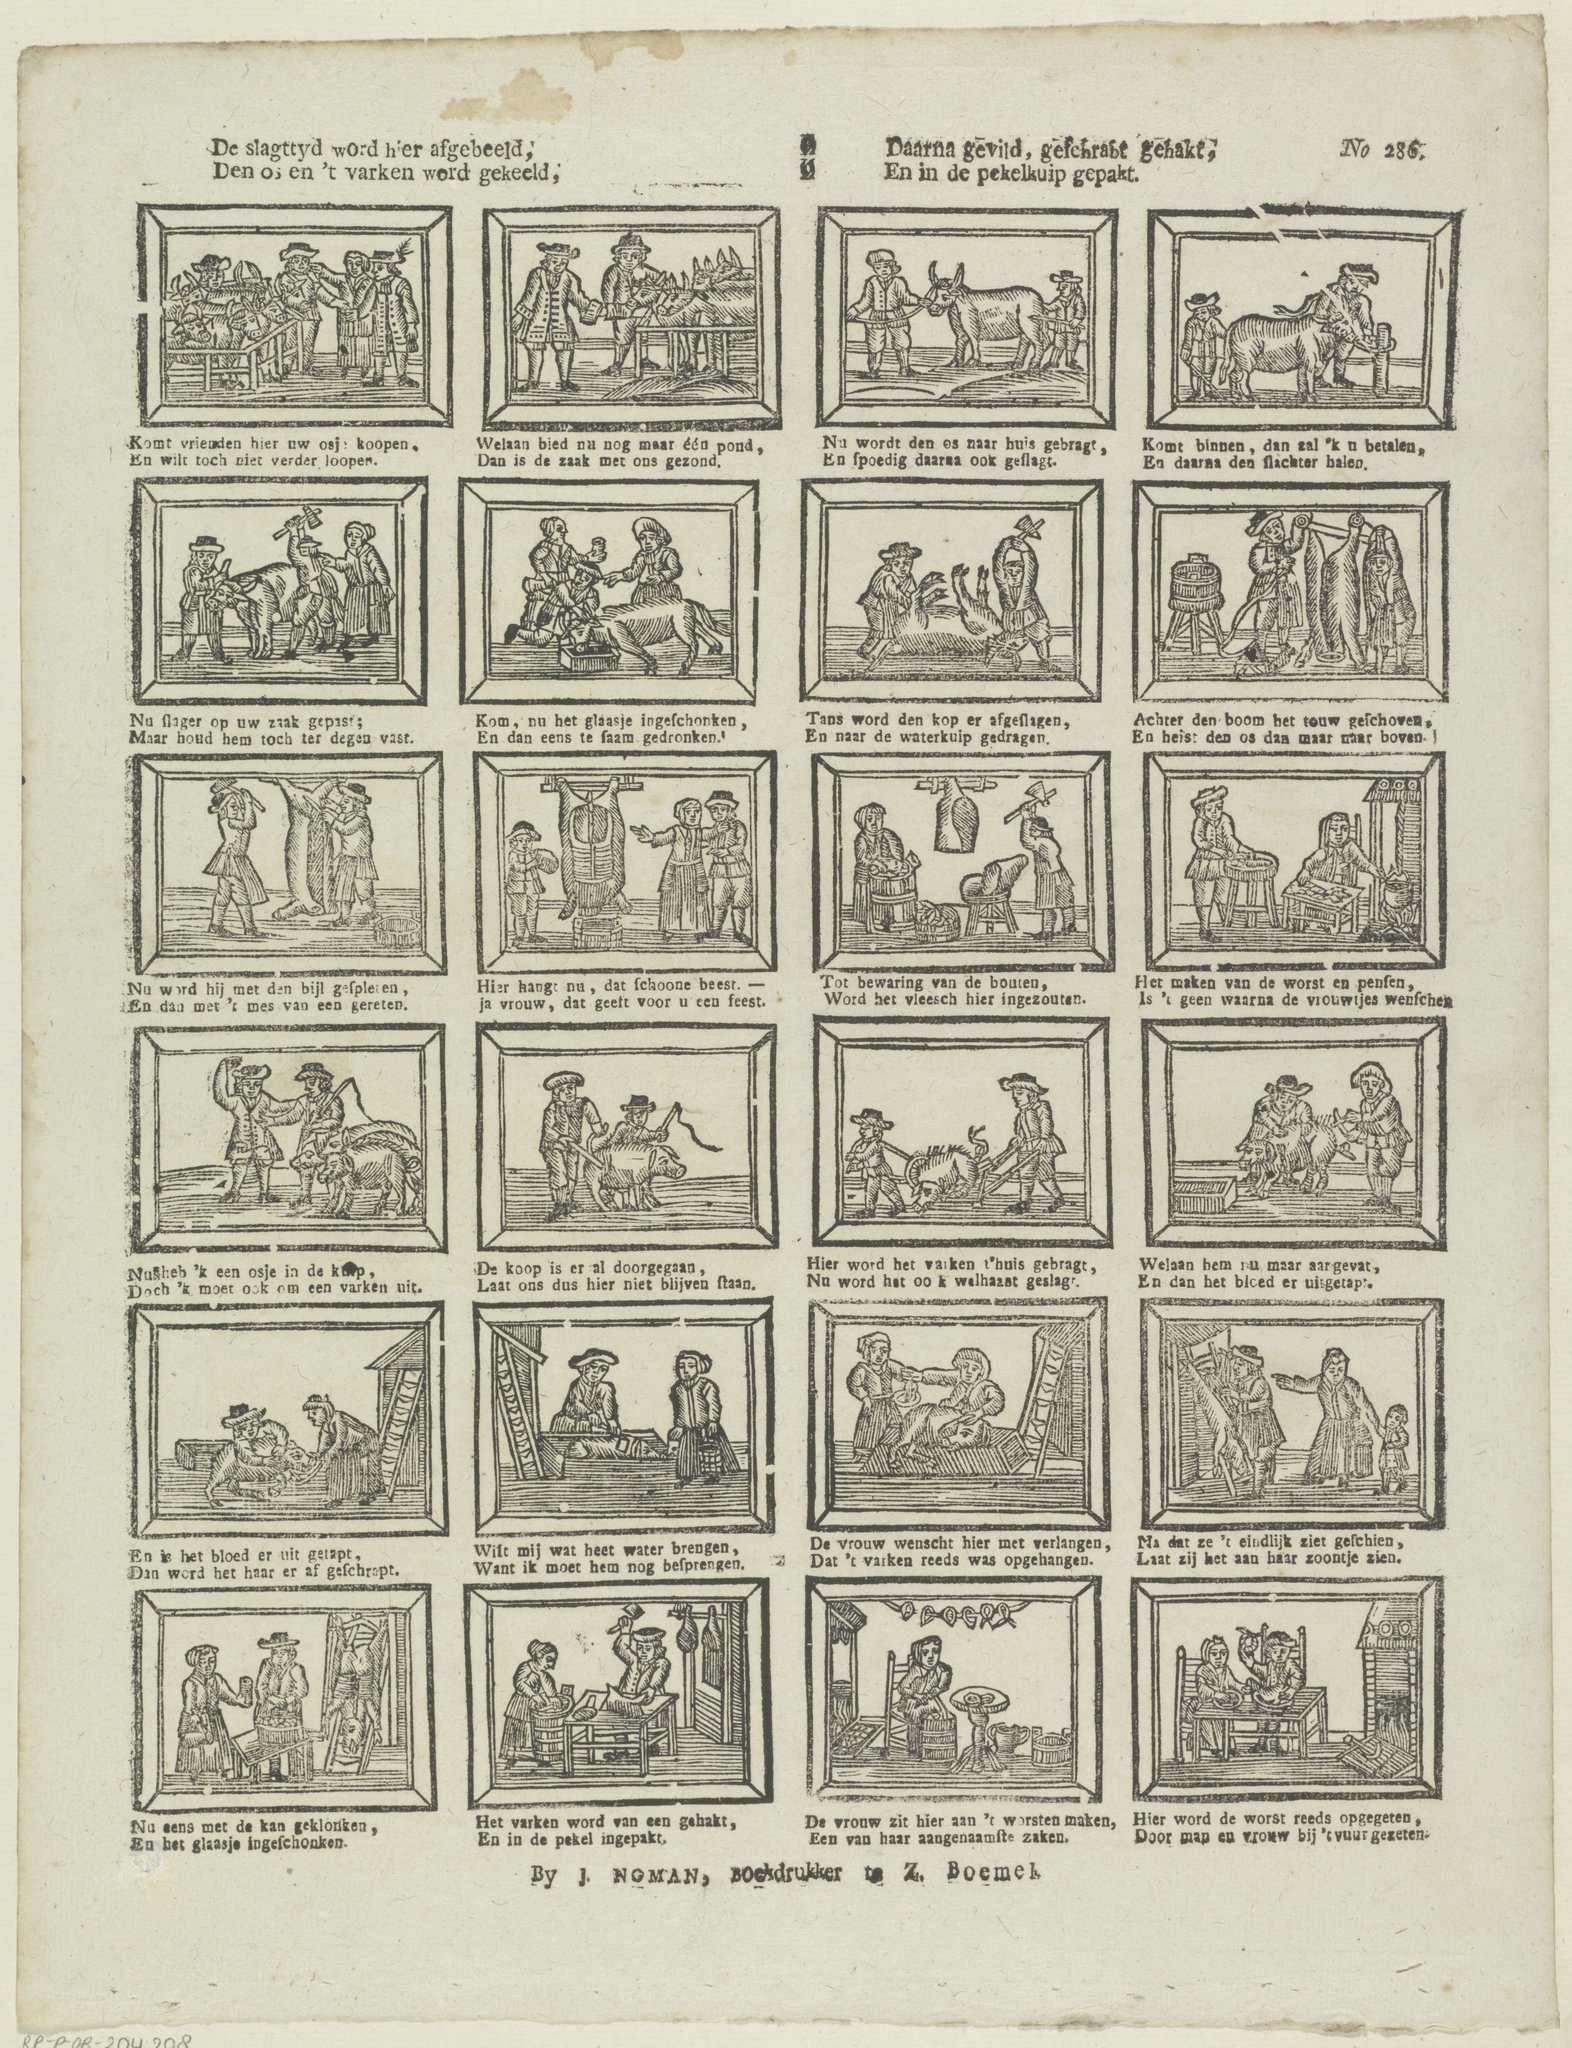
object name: print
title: De slagttyd word hier afgebeeld, / Den os en 't varken word gekeeld, / Daarna gevild, geschrabt gehakt, / En in de pekelkuip gepakt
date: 1806-1830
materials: paper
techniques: letterpress printing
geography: zaltbommel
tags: slaughtered ox or pig, butcher, slaughterman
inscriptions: collector's mark: Lugt 2760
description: Blad met 24 voorstellingen van het fokken, slachten en bereiden van koeien en varkens. Onder elke afbeelding een tweeregelig vers. Genummerd rechtsboven: No. 286.